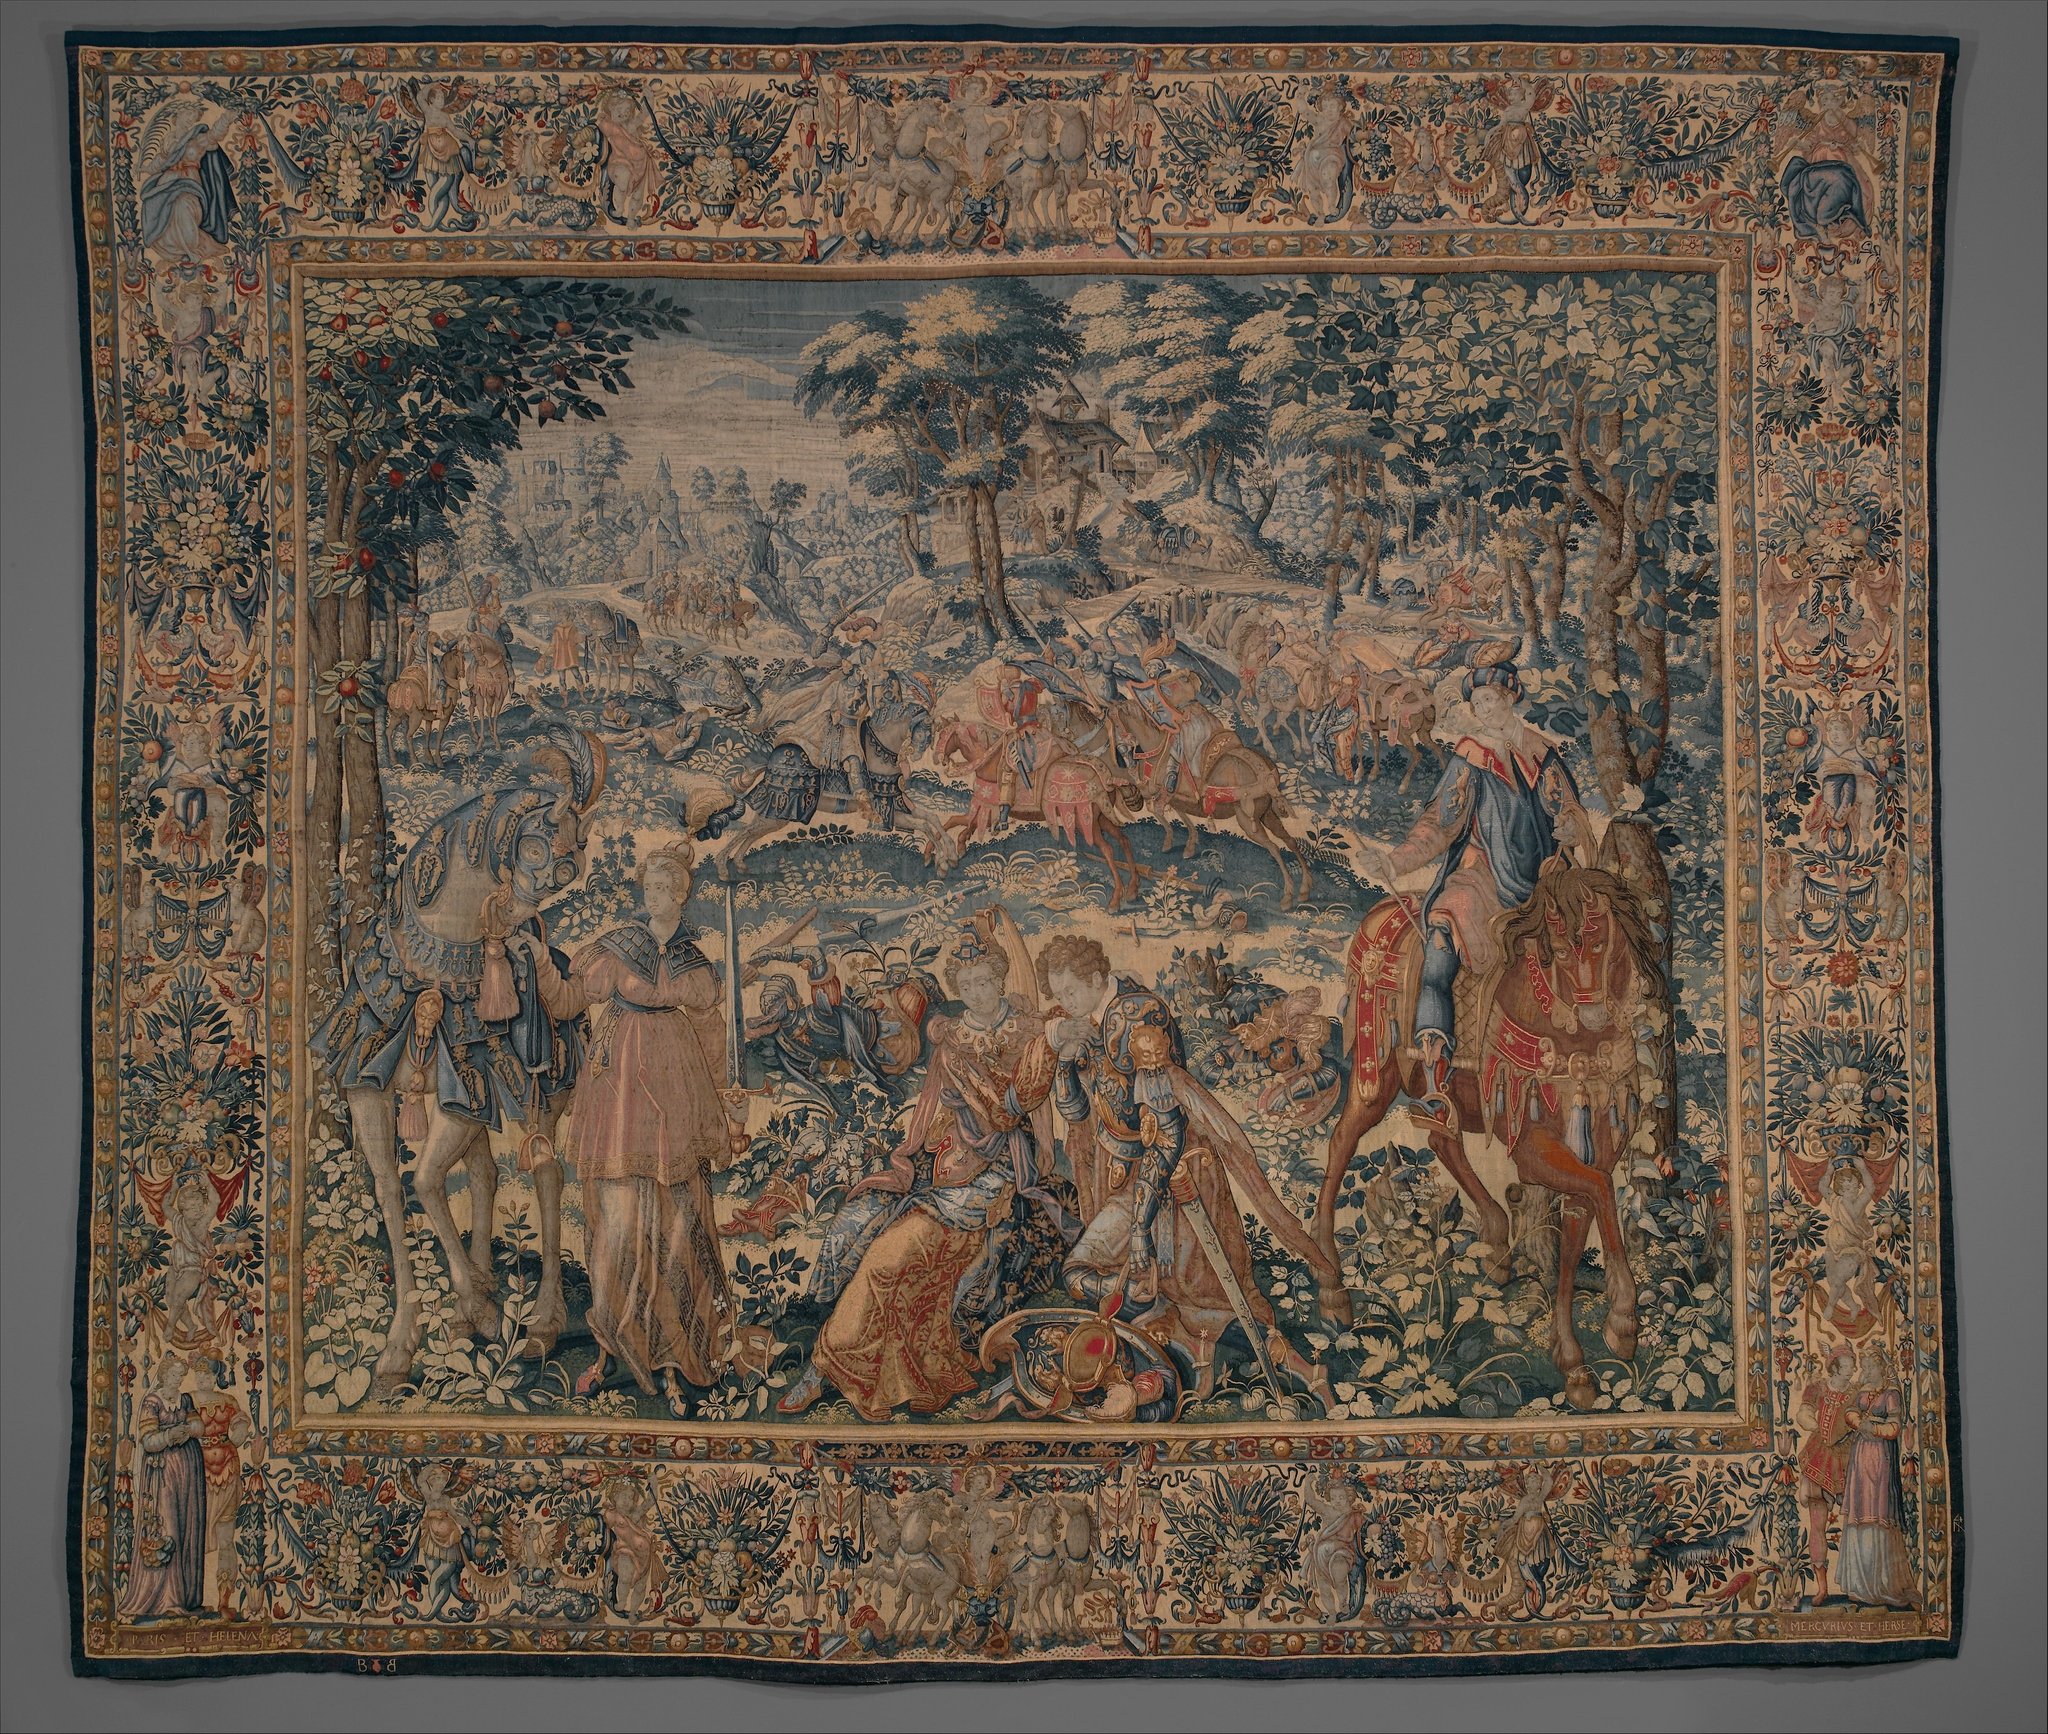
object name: tapestry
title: The Liberation of Oriane from a set of Amadis of Gaul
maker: karel van mander i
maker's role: designer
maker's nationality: netherlandish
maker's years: 1548-1606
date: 1590-1595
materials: silk, wool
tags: soldiers,men,women,horses